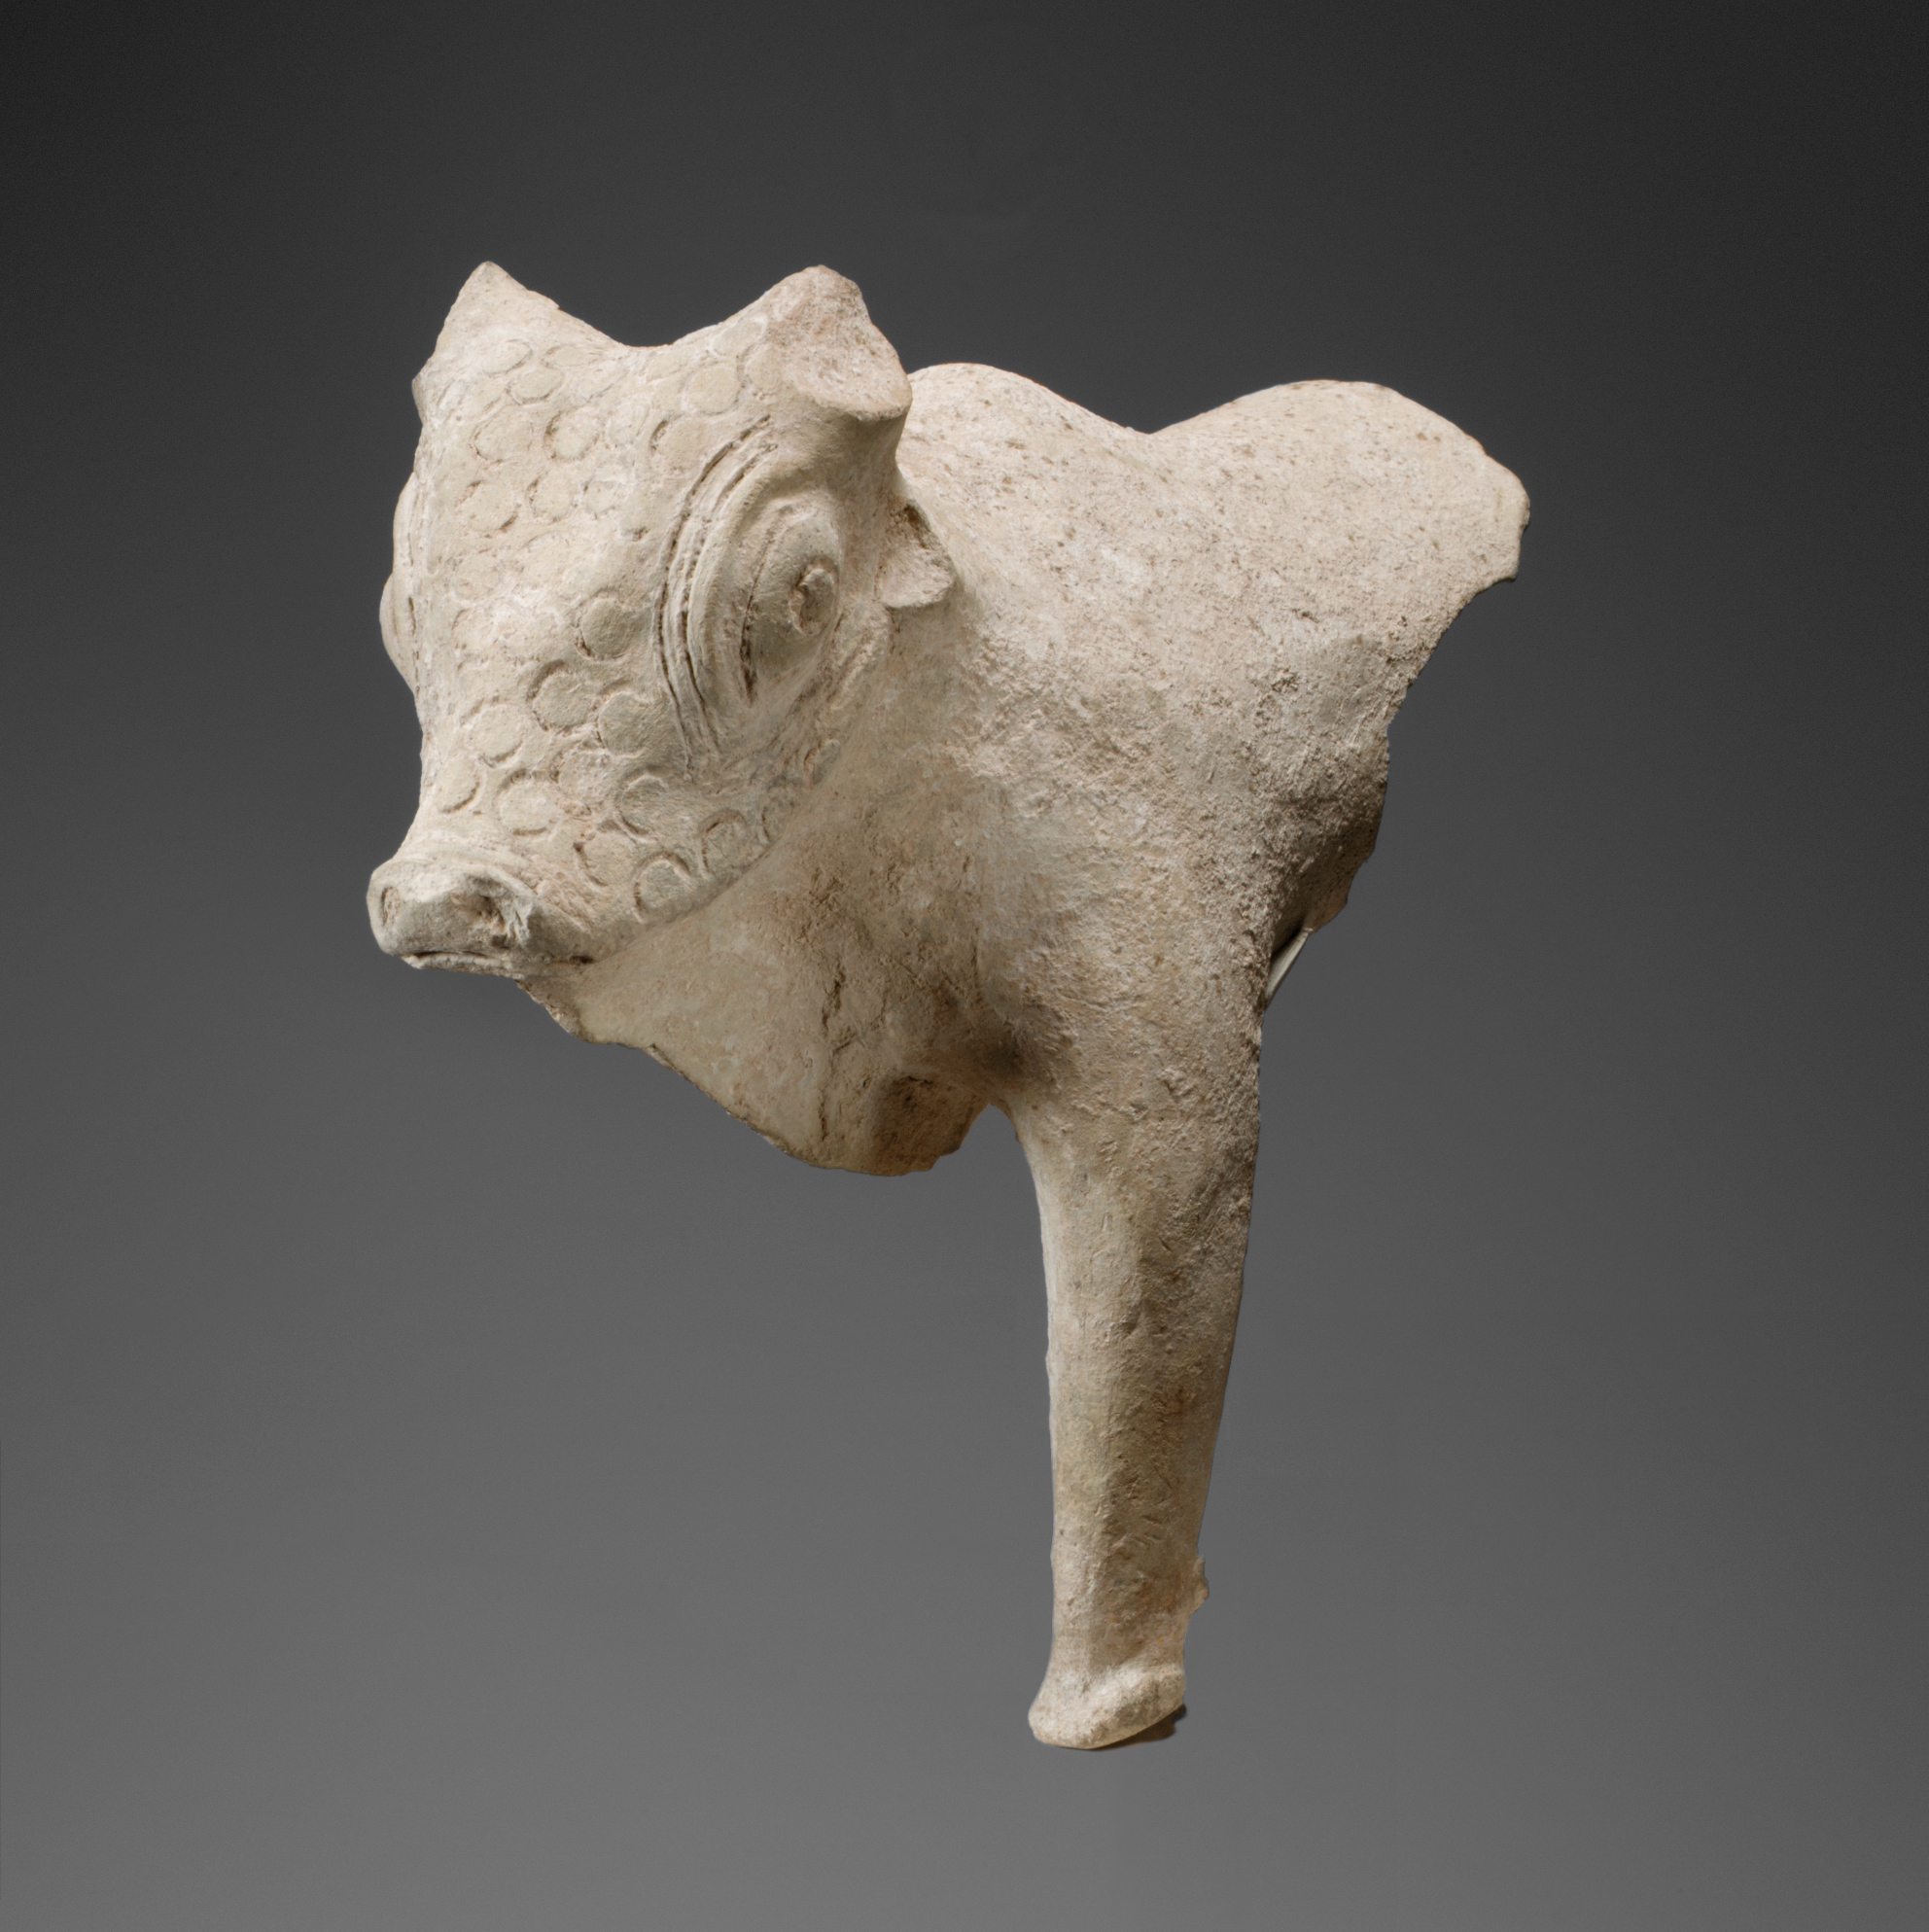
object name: statuette of a bull, fragmentary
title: Terracotta statue of a bull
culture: cypriot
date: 1200-1050 BCE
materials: terracotta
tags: bulls